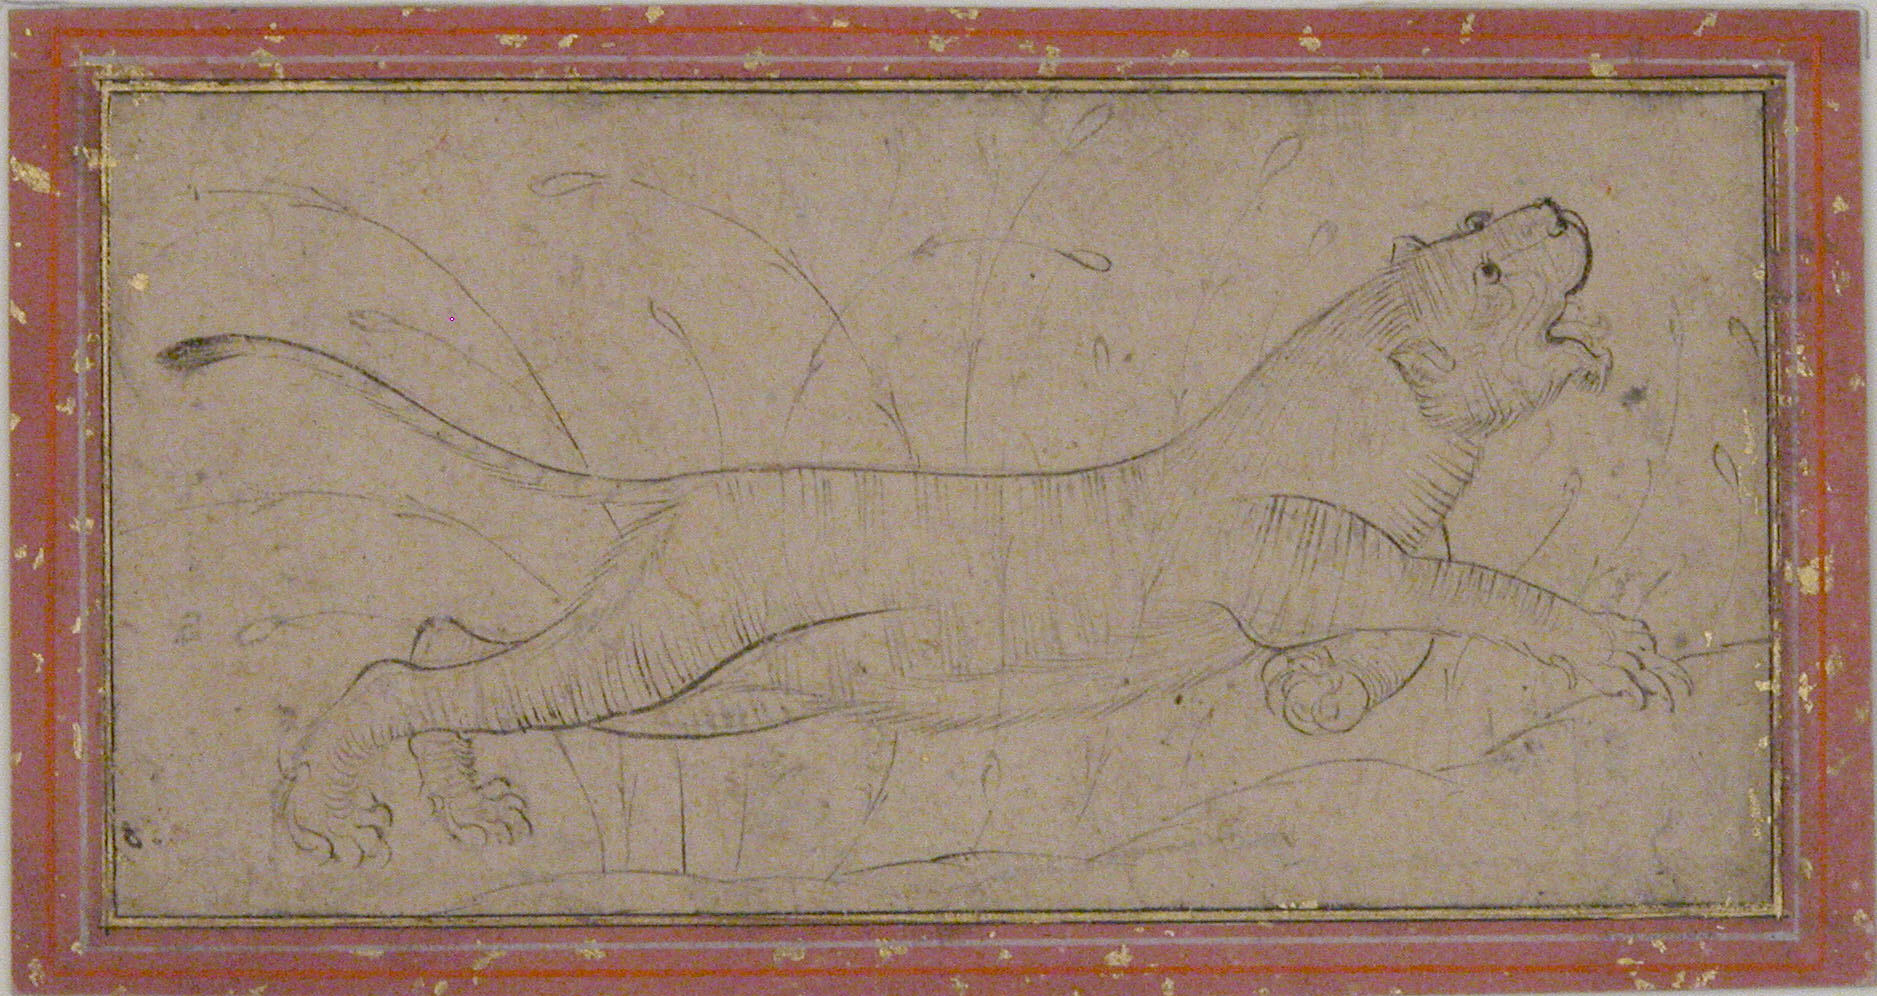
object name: illustrated single work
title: Lion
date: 1501-1600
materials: gold, ink, paper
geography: iran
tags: lions